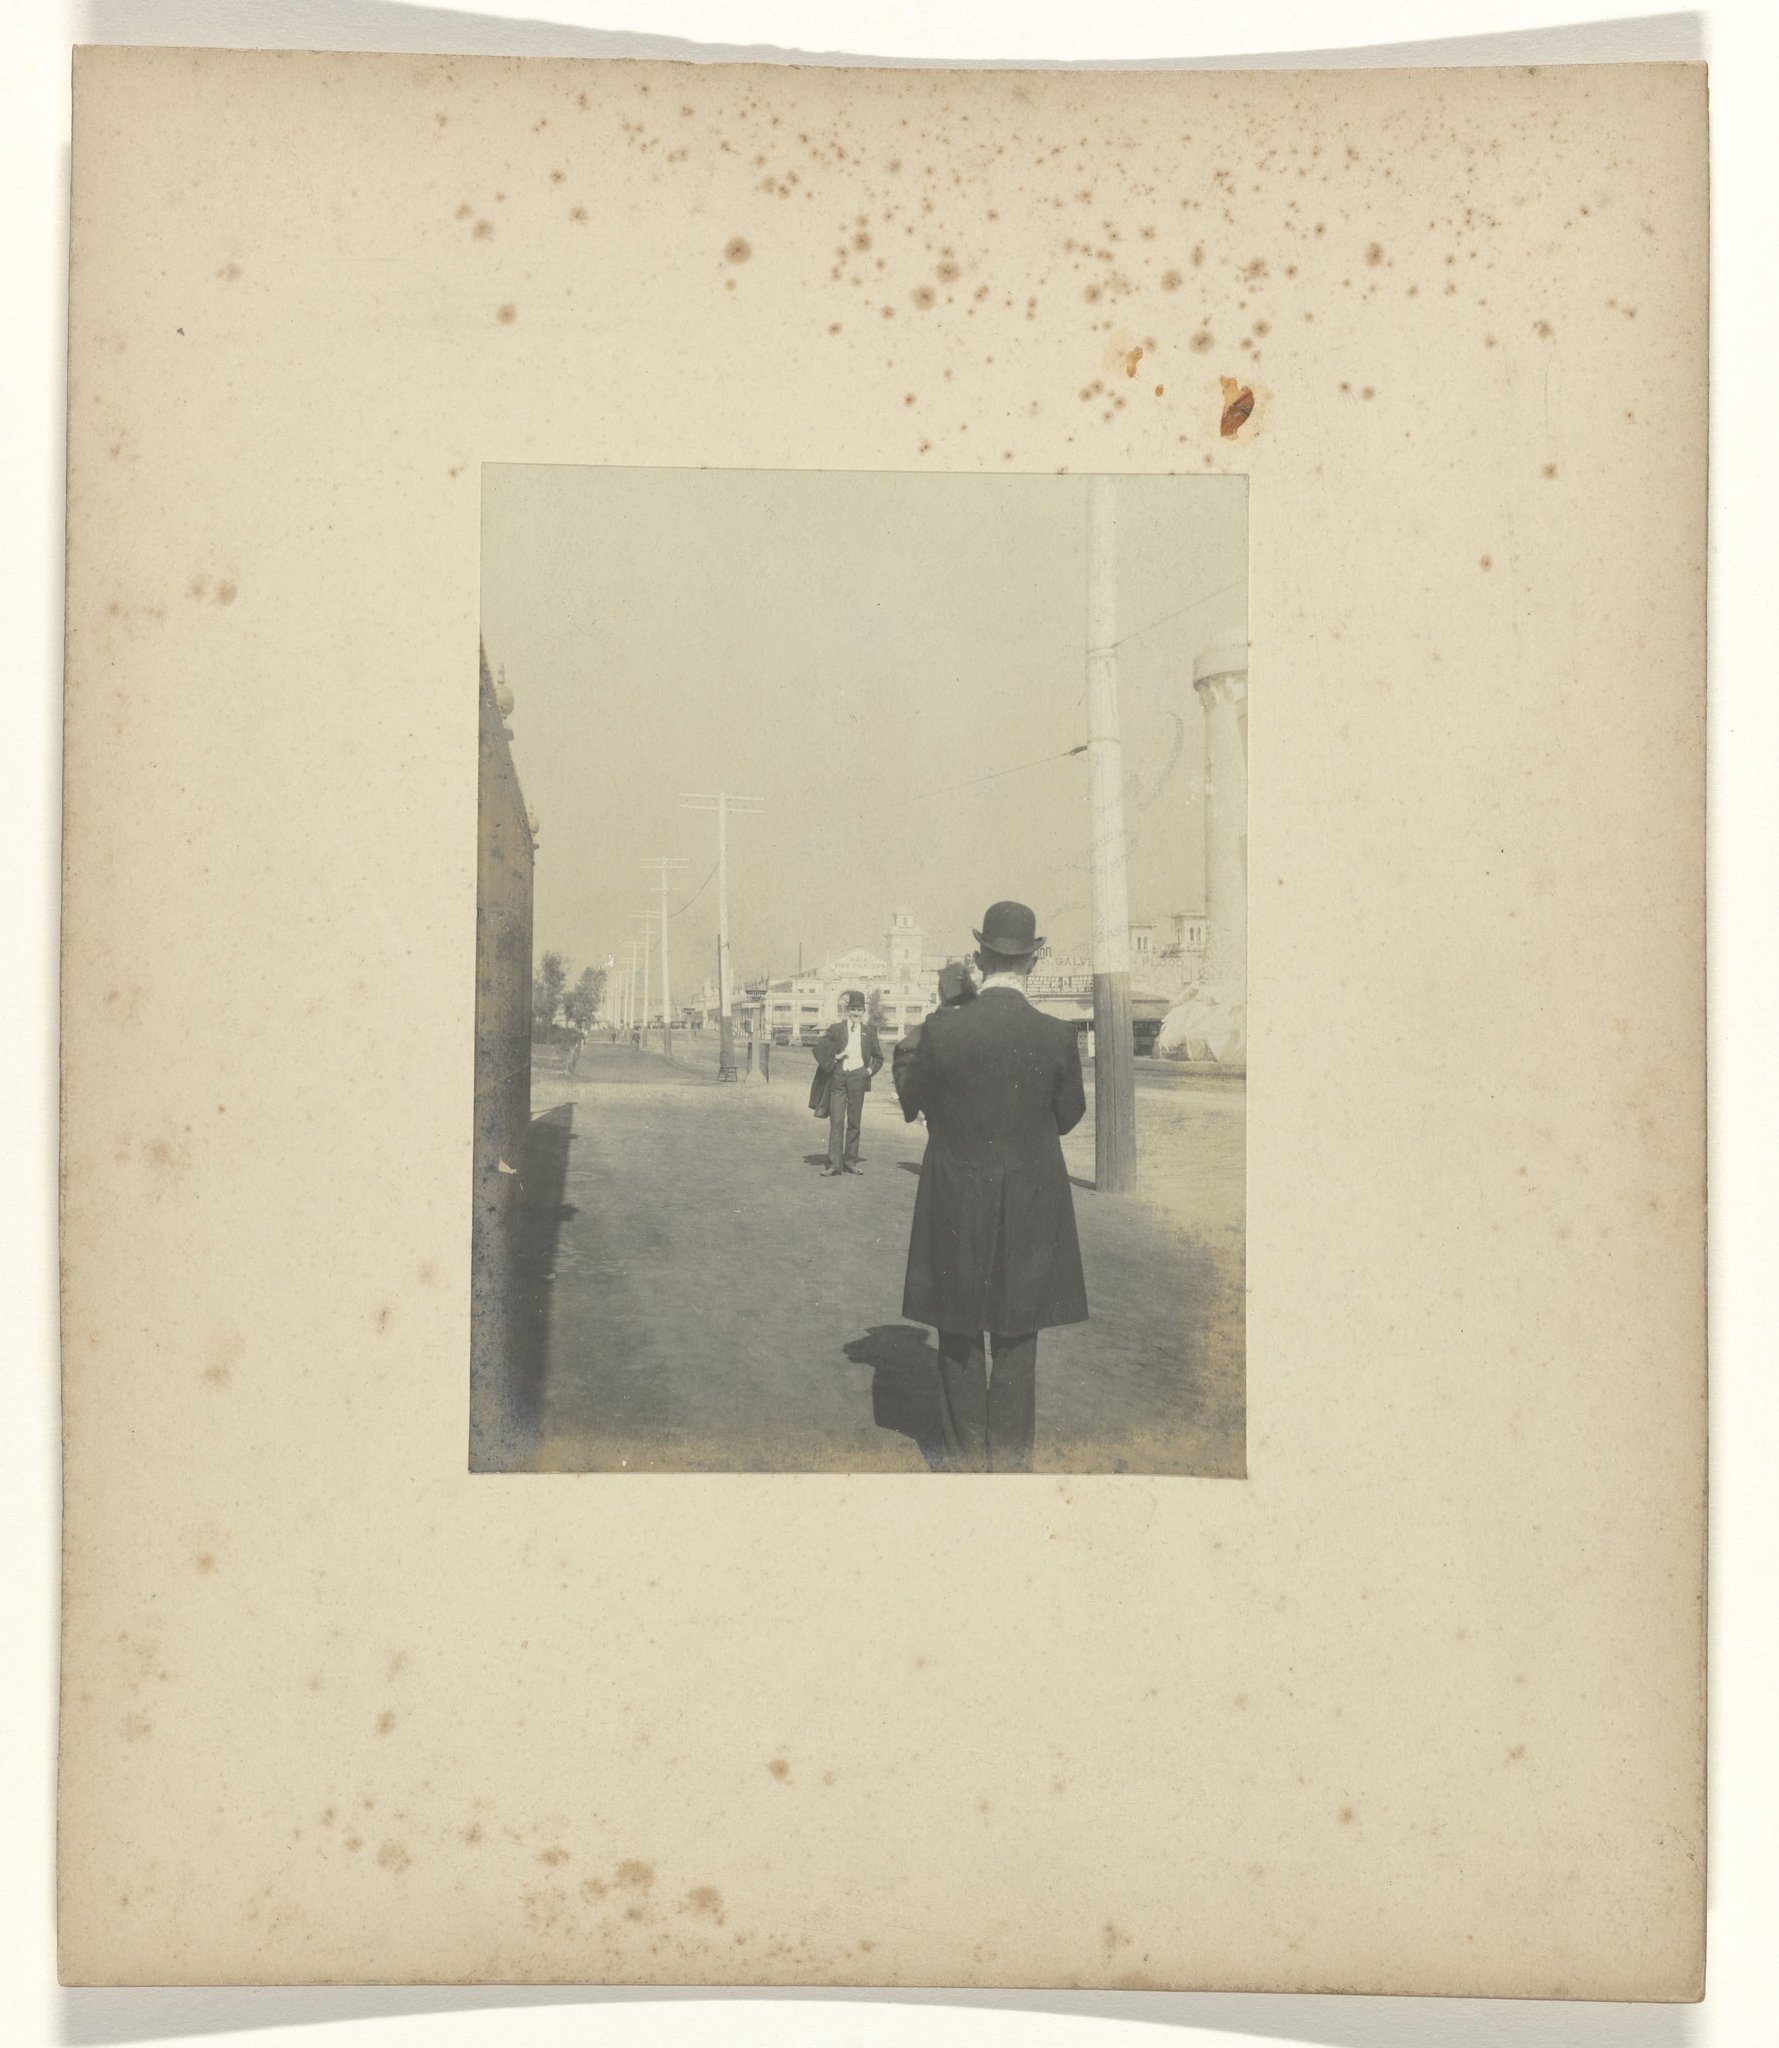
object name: photograph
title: Baekers fotografeert Tony Artz bij de uitgang van de wereldtentoonstelling in St. Louis (Louisiana Purchase Exposition), 1904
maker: jan schüller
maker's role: draughtsman, painter, print maker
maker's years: 1871-1915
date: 1904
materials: cardboard, paper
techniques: gelatin silver print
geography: saint louis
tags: tony artz, world fair, world exhibition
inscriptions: annotation: ‘Backers kiekt Tony // bij de uitgang’, annotation: ‘Tony’, annotation: ‘Artz’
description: Baekers fotografeert Tony Artz bij de uitgang van de wereldtentoonstelling in St. Louis (Louisiana Purchase Exposition), 1904.